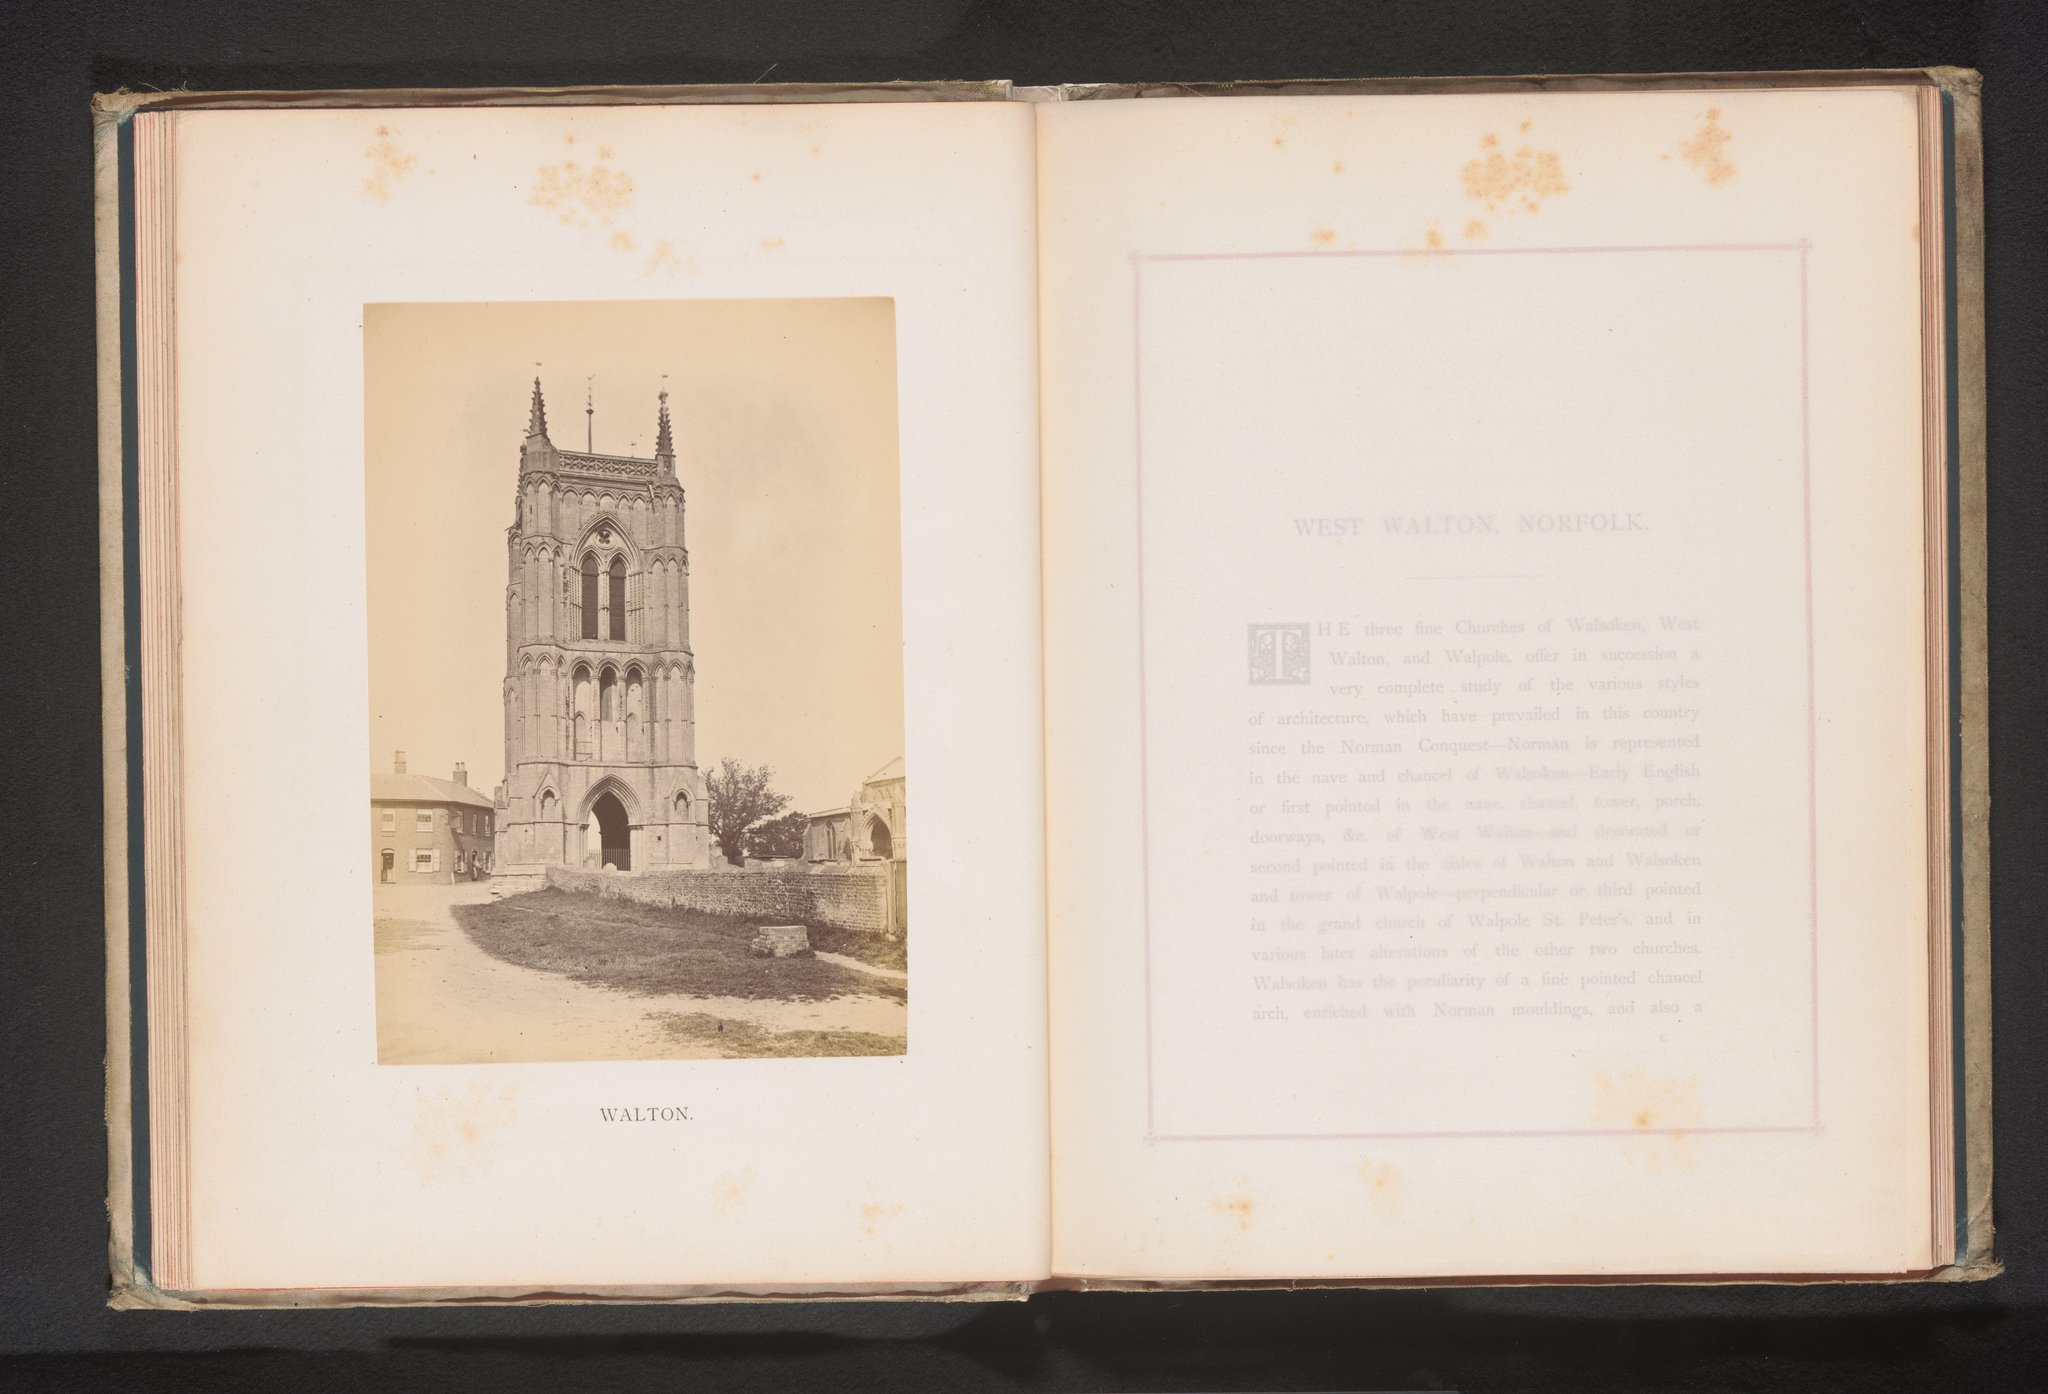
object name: page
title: Walton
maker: edward johnson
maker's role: fotograaf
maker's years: 1822-1907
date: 1858-1869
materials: photographic support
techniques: albumen print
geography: west walton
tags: parts of church exterior and annexes: campanile, façade (of house or building)